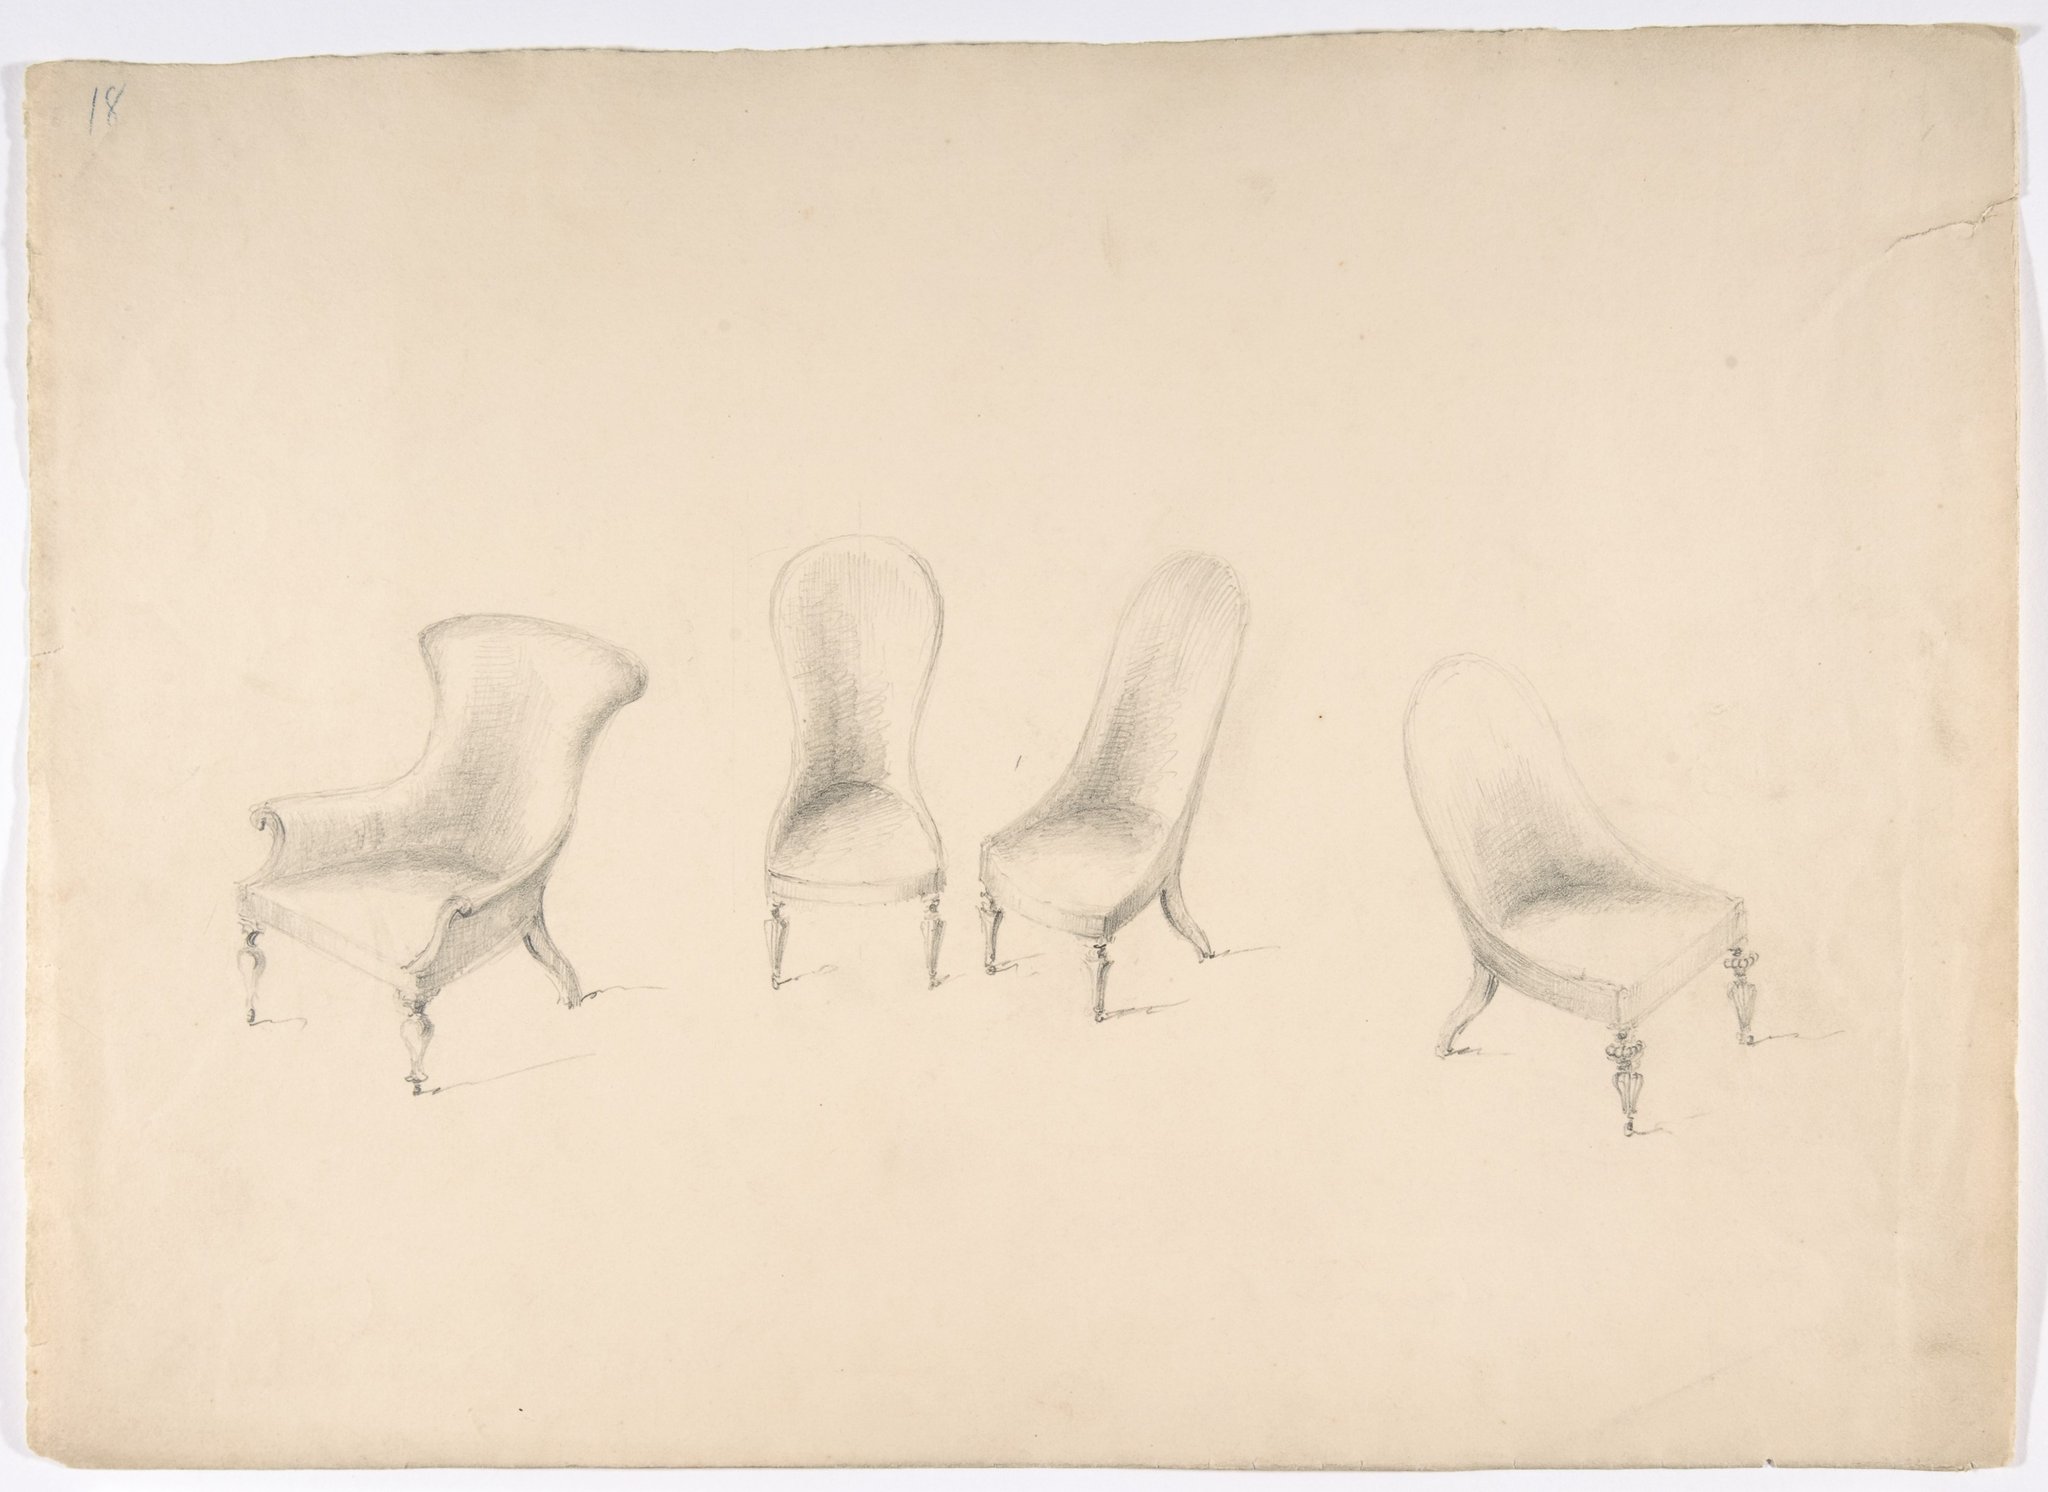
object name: drawing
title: Design for Four Uphostered Chairs on Casters, One with Arms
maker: anonymous, british, 19th century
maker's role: artist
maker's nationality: british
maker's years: 1800-1900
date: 1801-1833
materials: graphite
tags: chairs